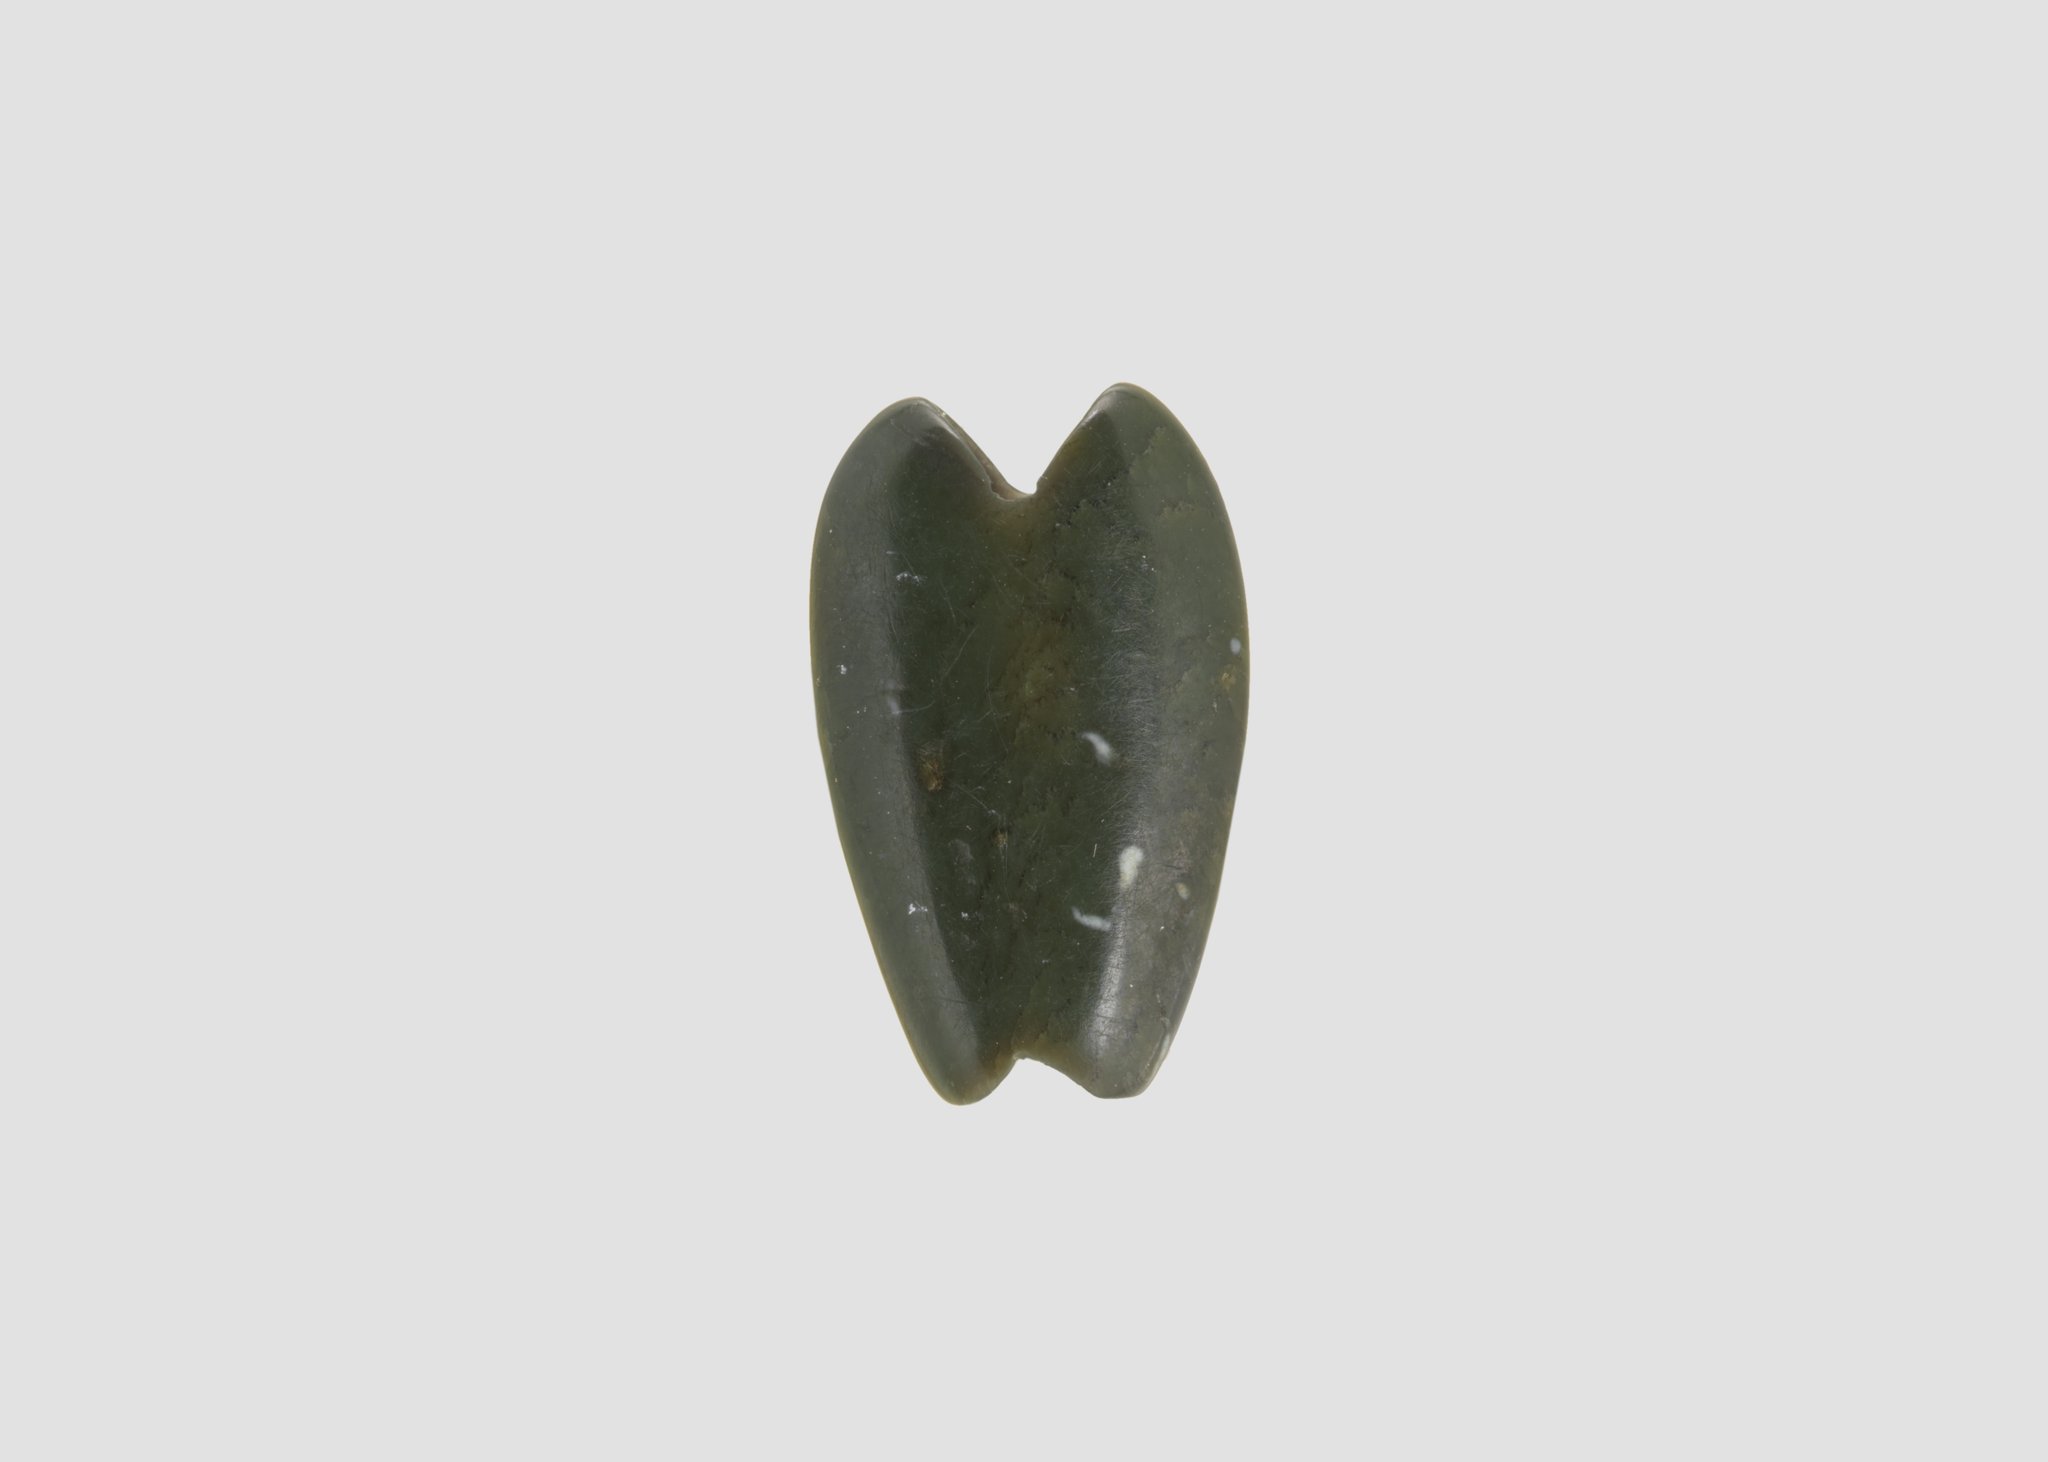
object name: bead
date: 7000-5001 BCE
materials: stone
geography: syria